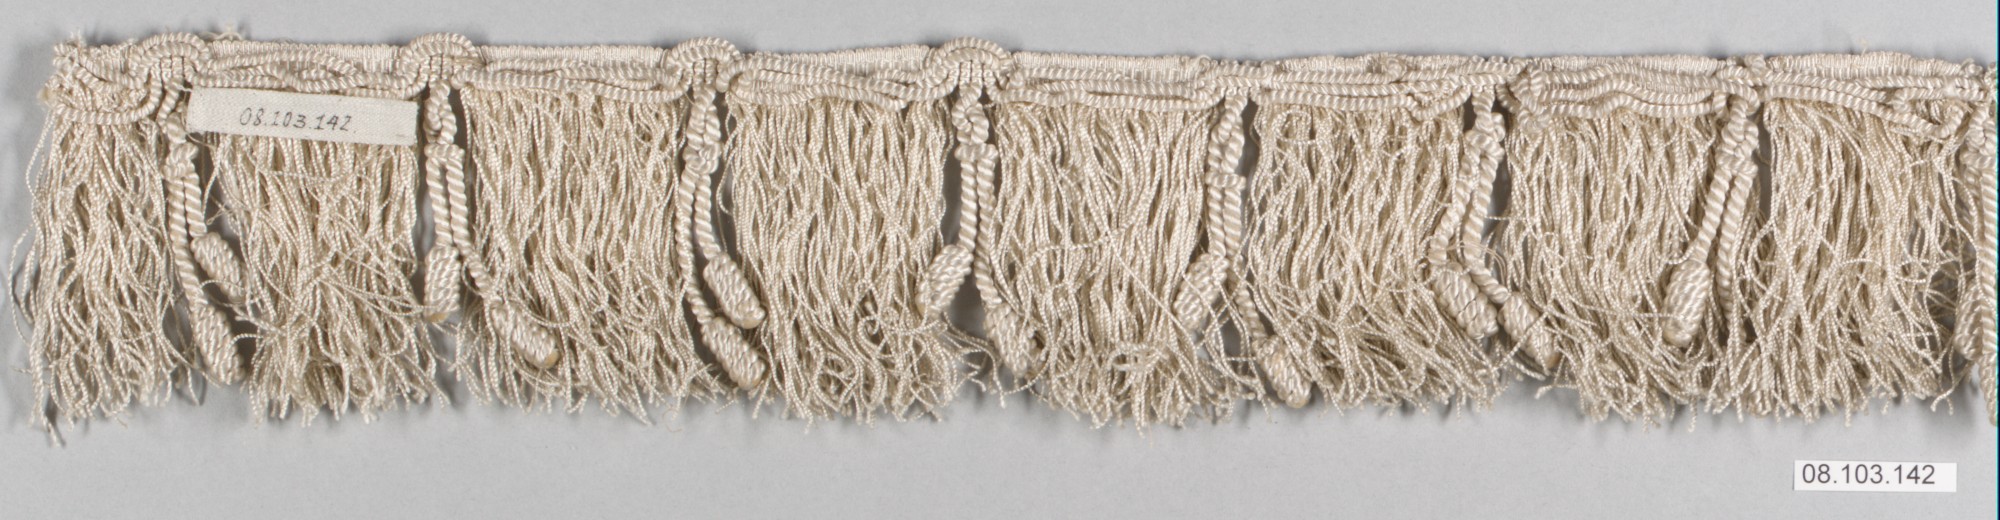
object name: fringe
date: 1880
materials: silk